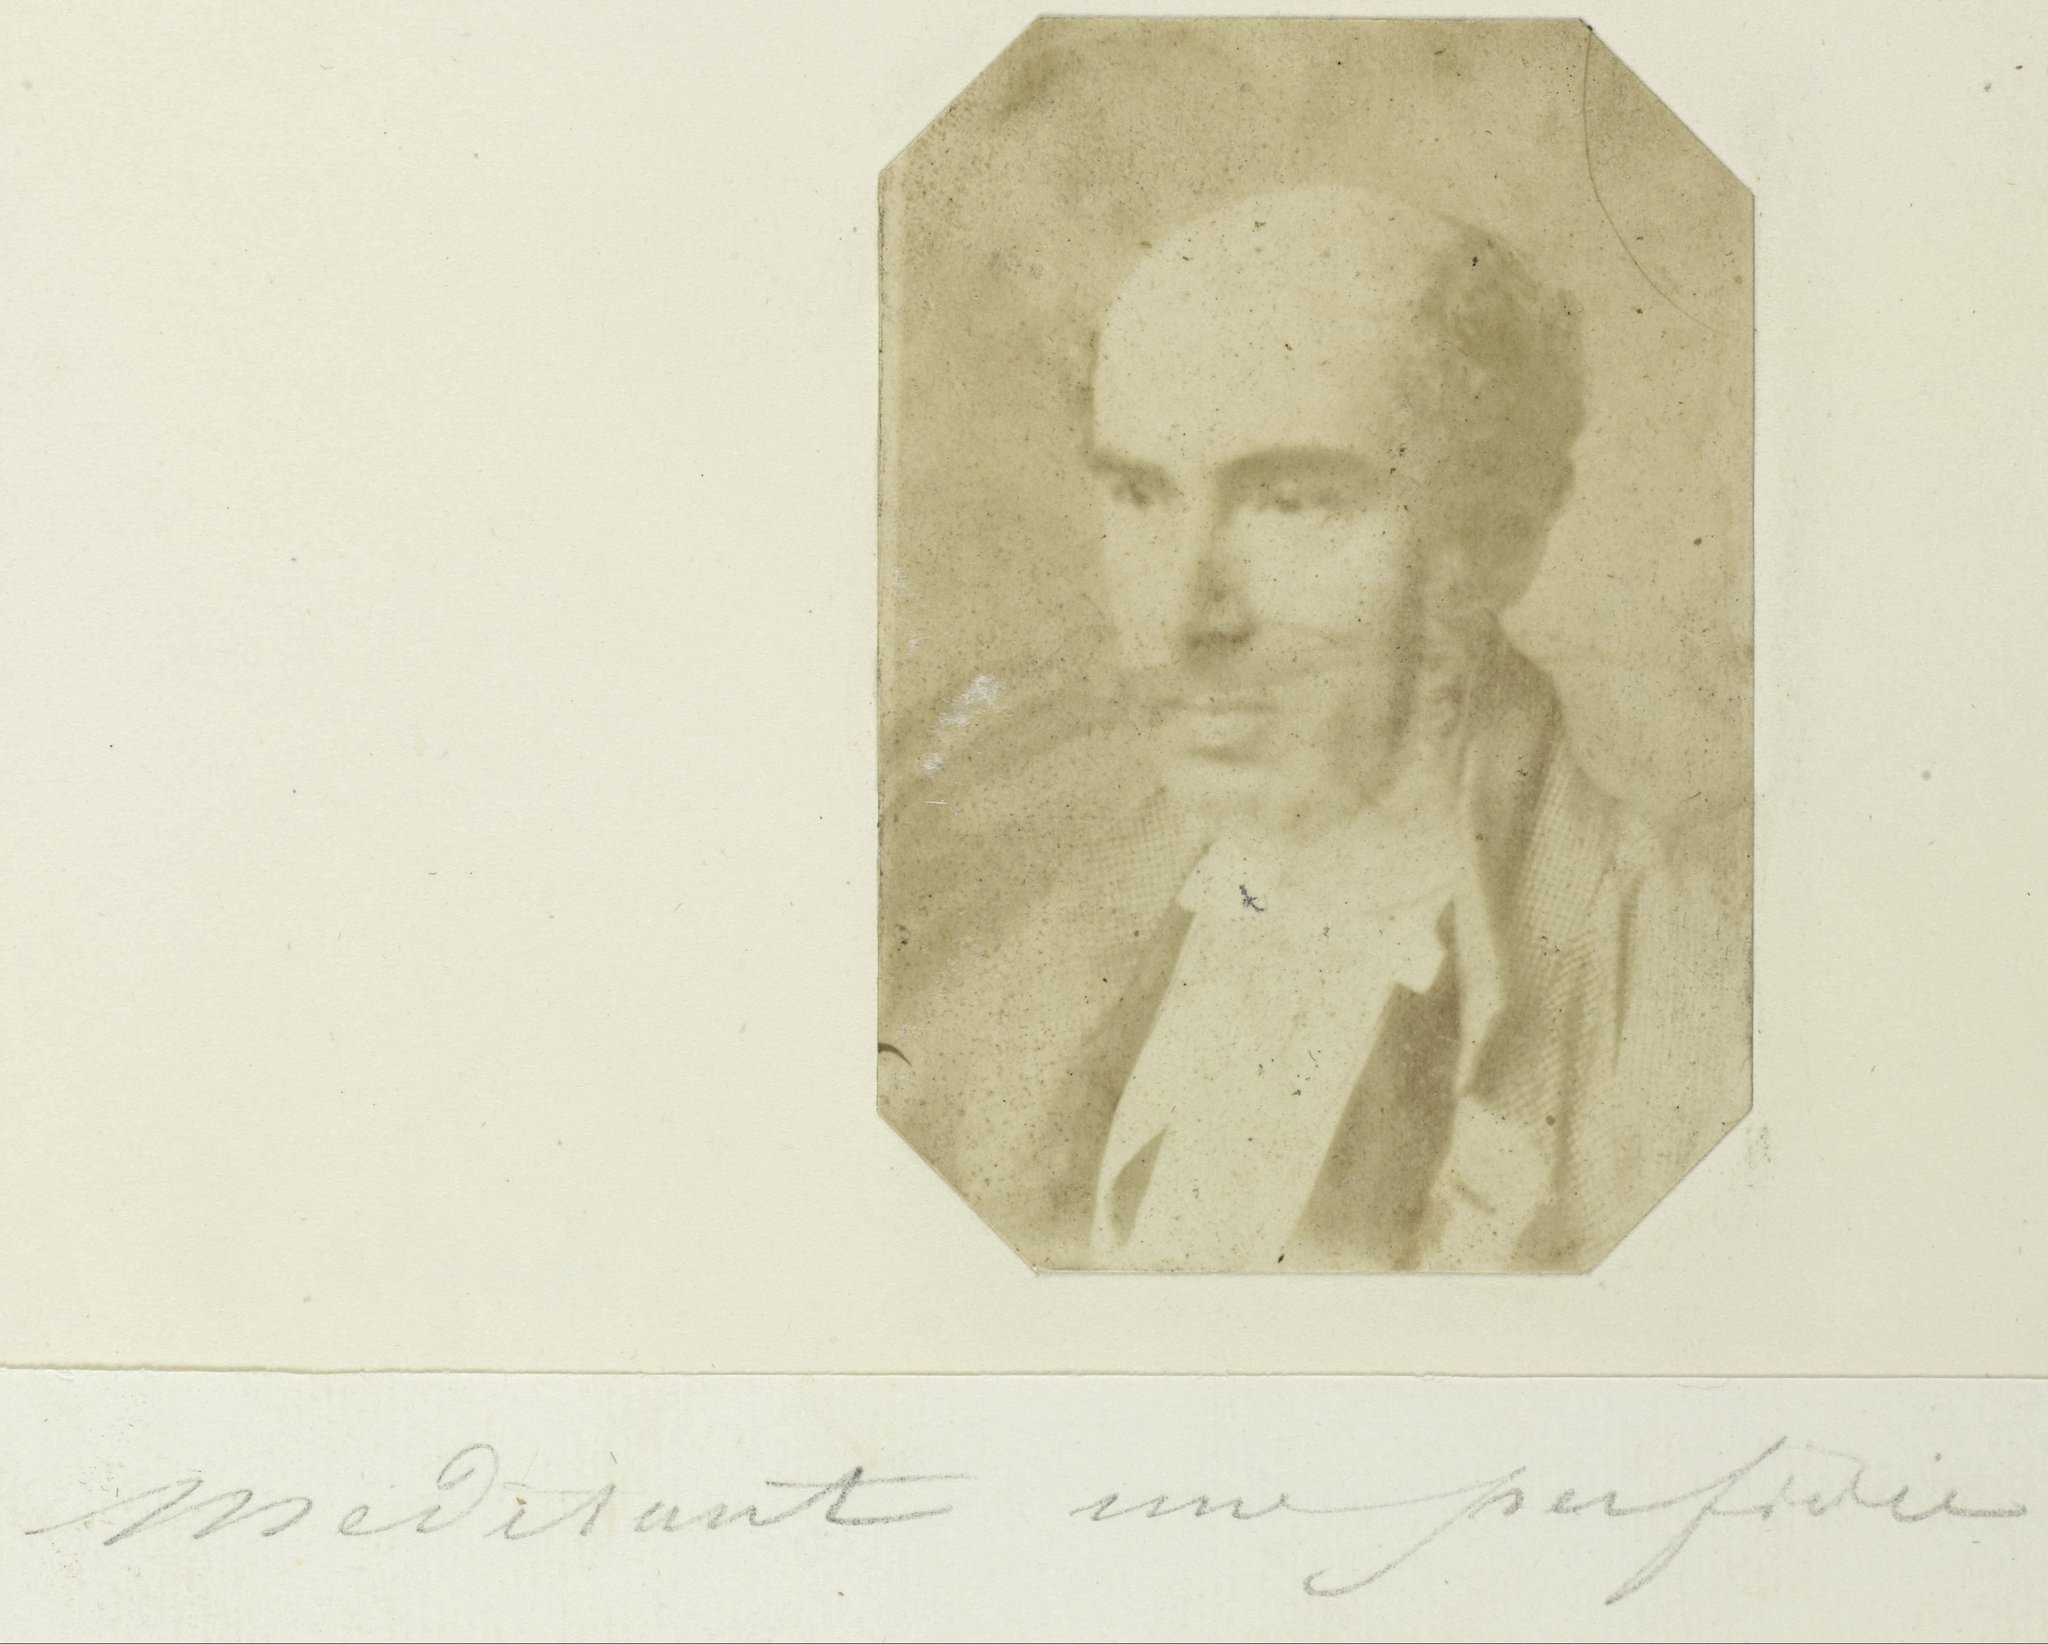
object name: photograph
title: Zelfportret, 'Meditant une perfidie'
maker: eduard isaac asser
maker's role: amateurfotograaf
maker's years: 1809-1894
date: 1845-1855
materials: cardboard, paper, photographic support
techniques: salted paper print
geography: amsterdam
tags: amsterdam, eduard isaac asser, portrait, self-portrait of photographer